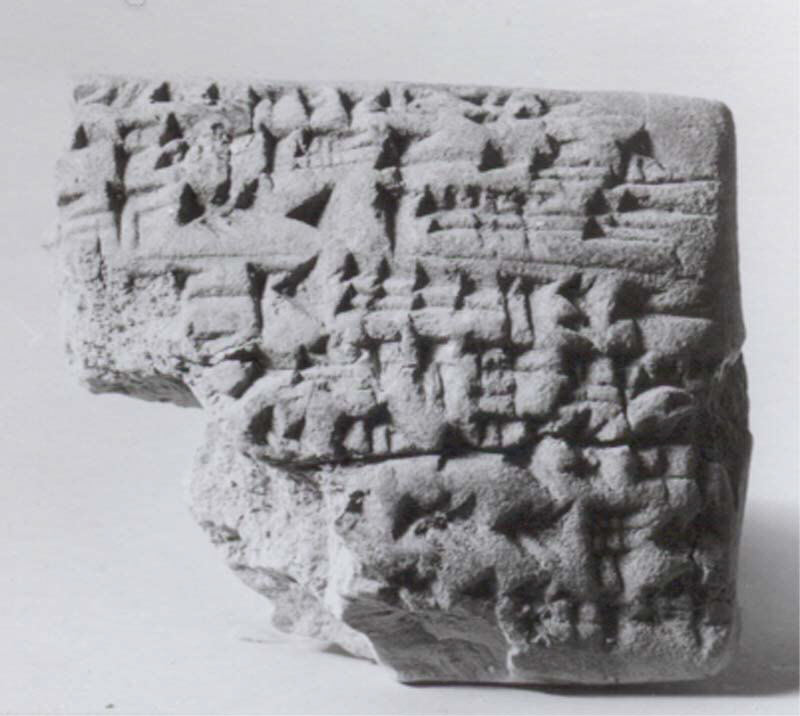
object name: cuneiform tablet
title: Cuneiform tablet: account of barley as agricultural dues, Ebabbar archive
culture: babylonian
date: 566 BCE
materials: clay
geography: mesopotamia